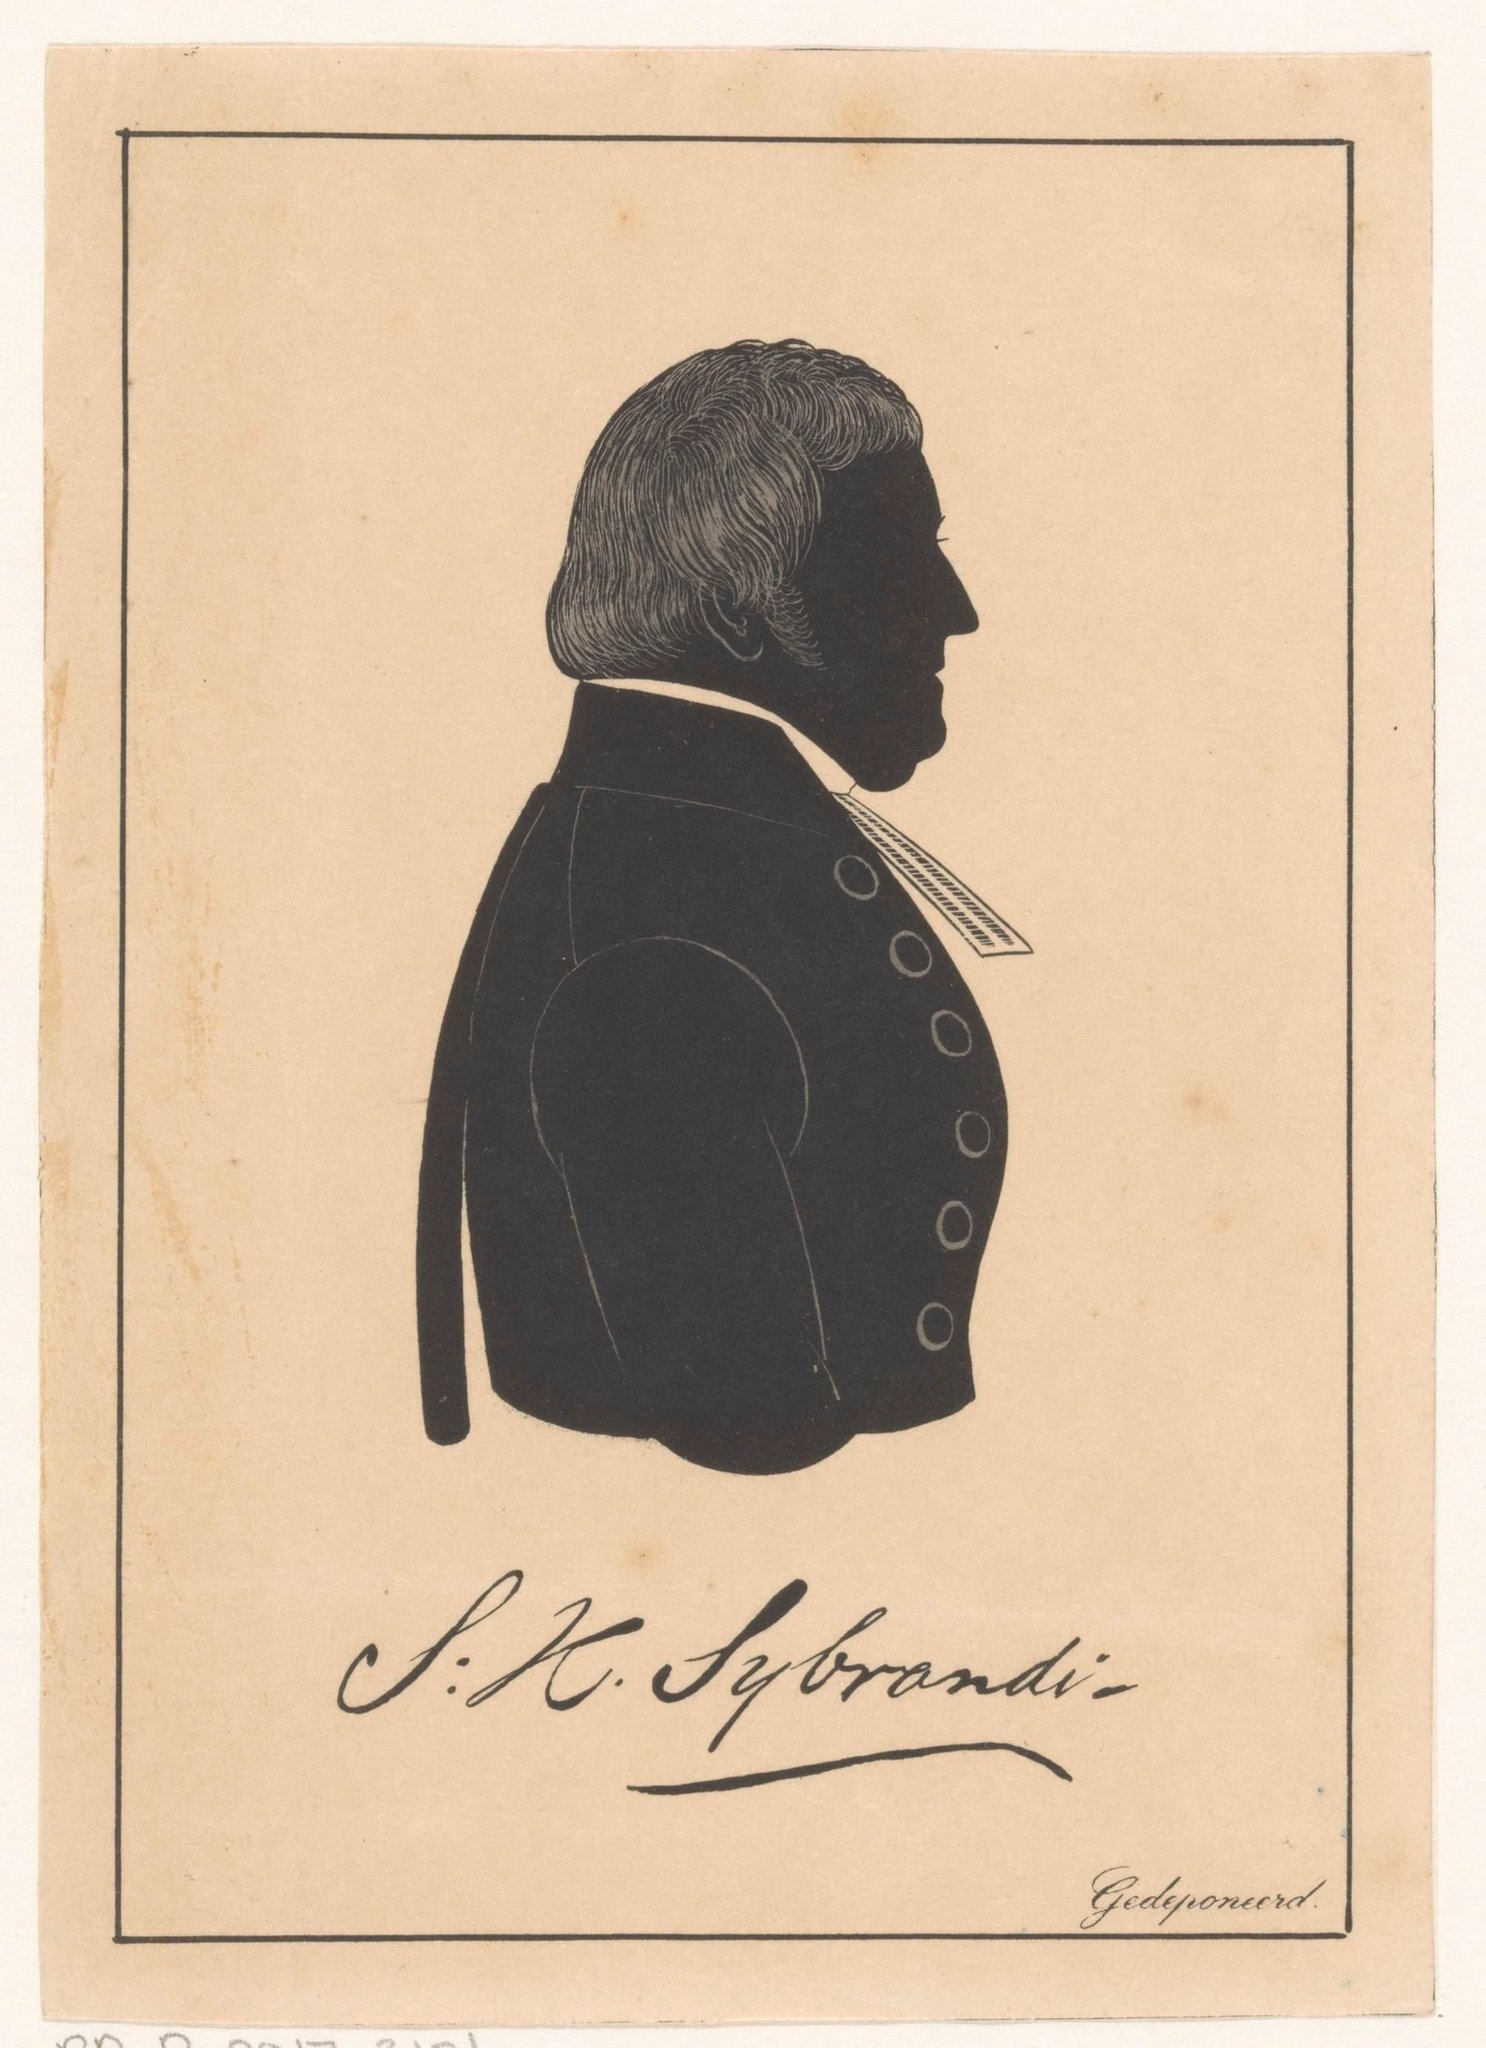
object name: print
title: Silhouetportret van Sybren Klases Sybrandi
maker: pieter barbiers (iv)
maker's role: painter, print maker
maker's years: 1798-1848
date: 1809-1848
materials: paper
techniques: hand coloring, lithograph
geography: netherlands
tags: historical persons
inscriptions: : ‘Gedeponeerd.’, collector's mark: Lugt 2228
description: Onder het portret de signatuur van de geportretteerde.